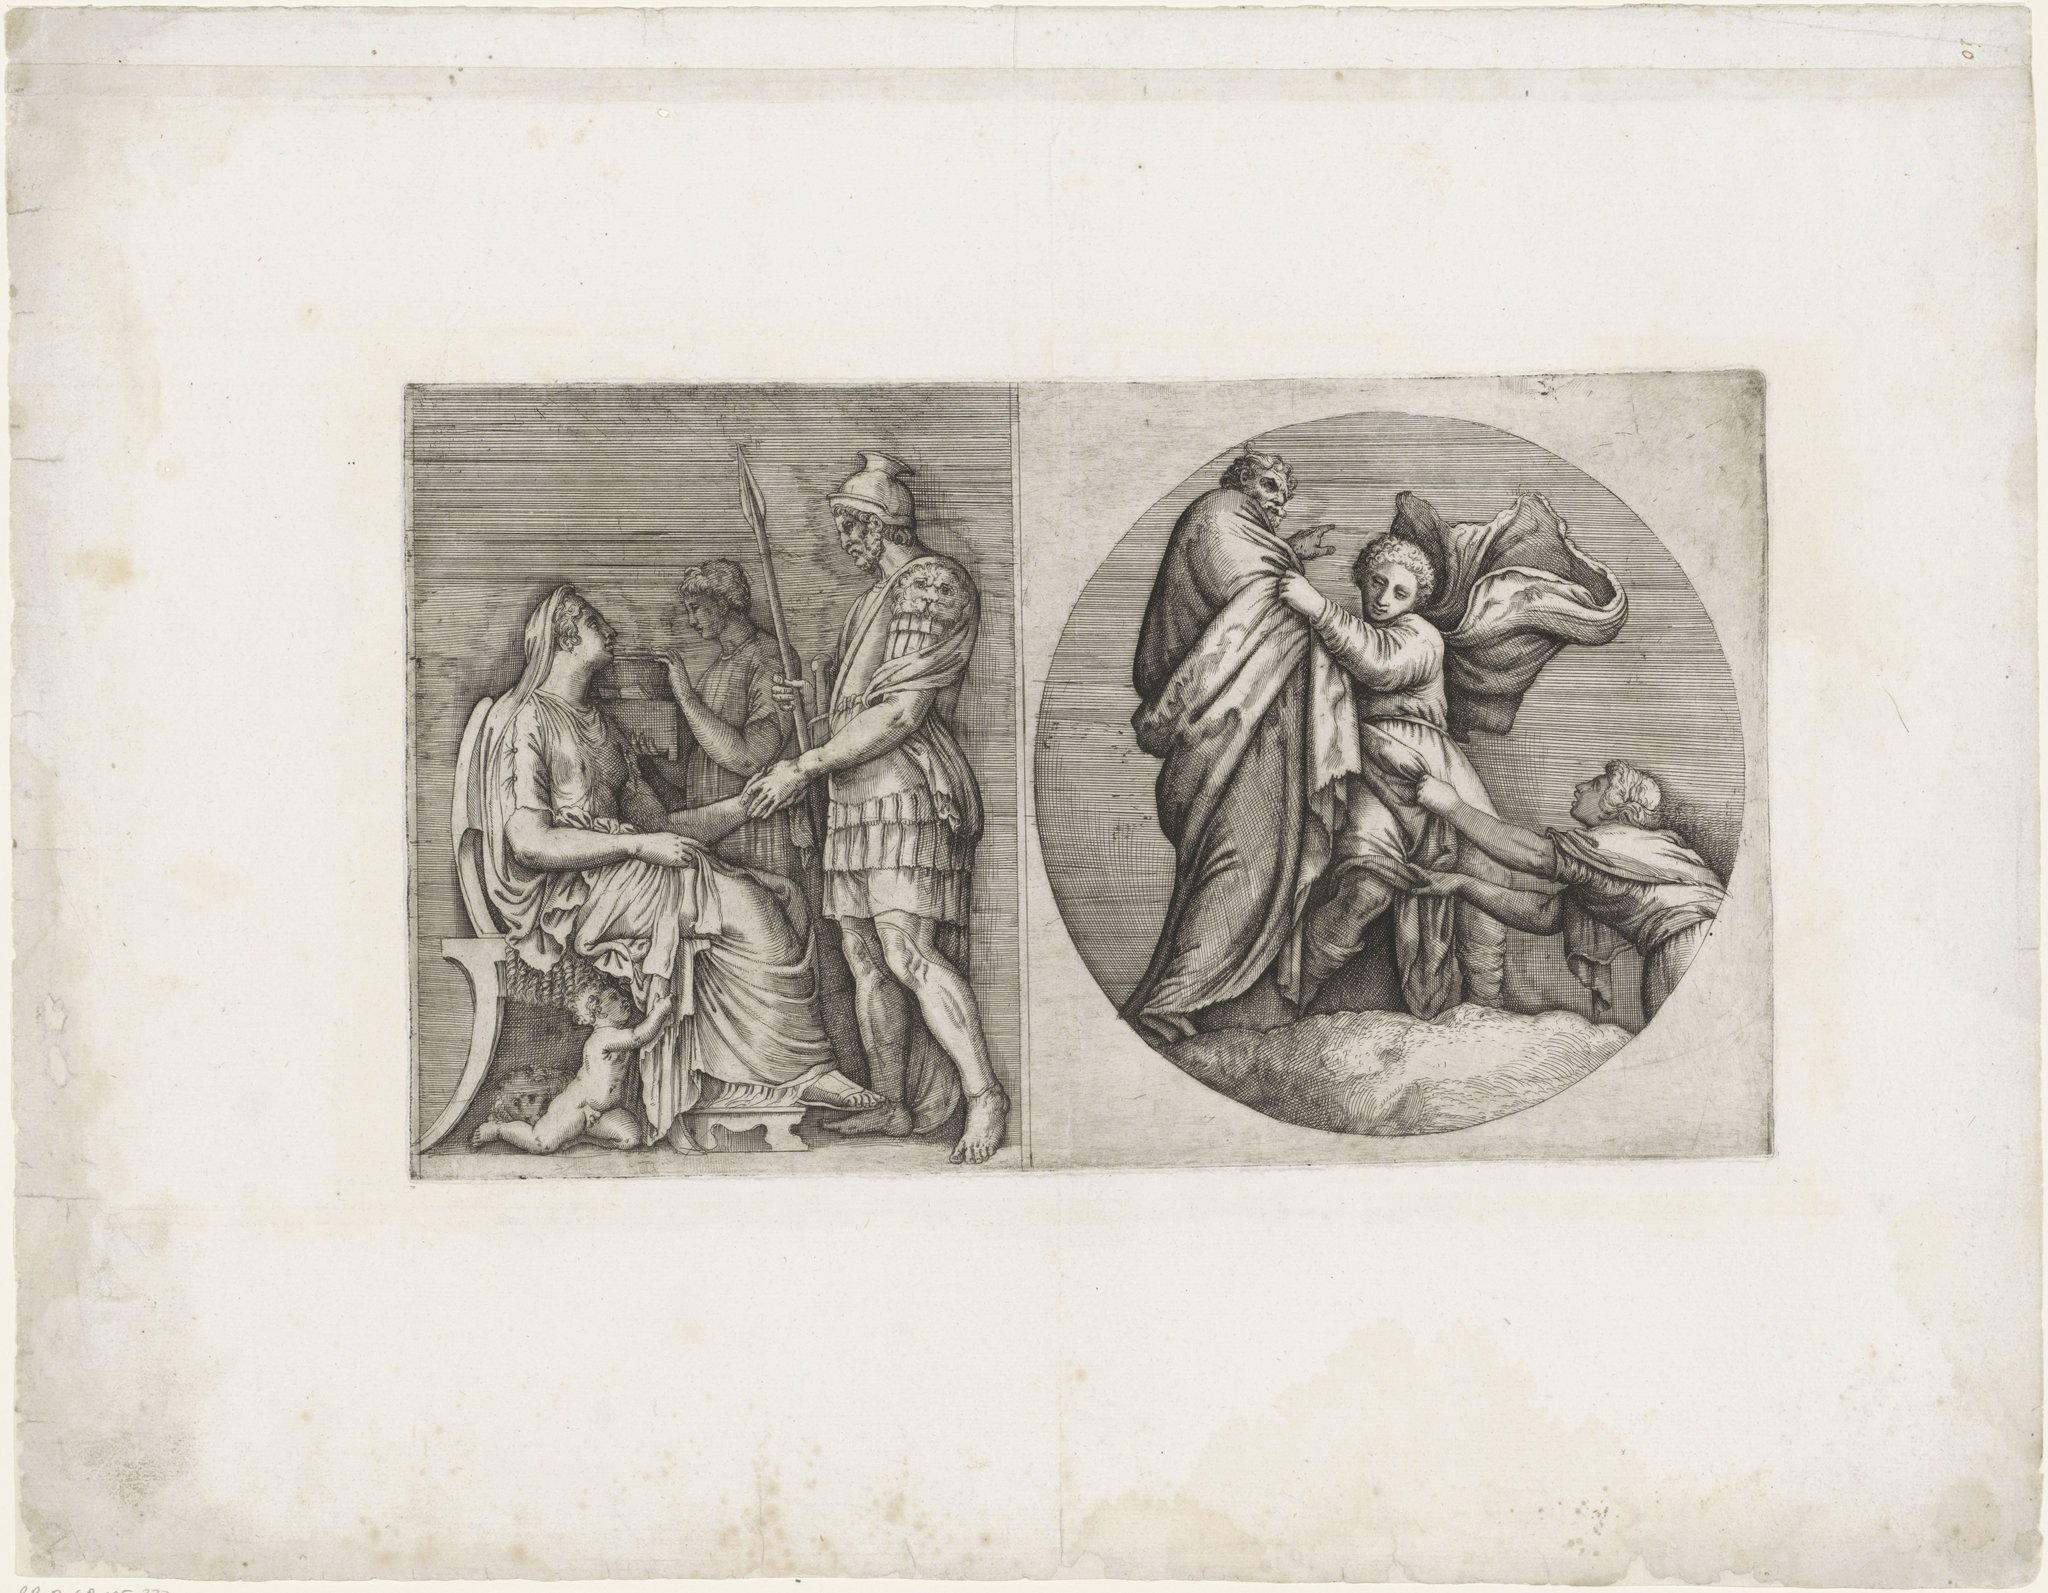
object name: album leaf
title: Romeinse soldaat begroet Romeinse dame / Allegorie: een jongen klampt zich vast aan een oude man, terwijl een vrouw aan zijn gewaad trekt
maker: battista franco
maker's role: draughtsman, painter, print maker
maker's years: 1510-1561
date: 1520-1561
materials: paper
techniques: etching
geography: venice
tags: wisdom; 'sapienza', 'sapienza humana', 'sapienza vera' (ripa), the soldier; the soldier's life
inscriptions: number: ‘10’, collector's mark: Lugt 2228, watermark, collector's mark: Lugt 2760, watermark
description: Folio 10 uit het prentalbum van Johann Georg I. Zobel von Giebelstadt (Röttingen 1543-07-20 - Bamberg 1580-09-07), de latere bisschop van Bamberg. Het album is vermoedelijk samengesteld tussen 1568 en 1570 in Venetië. Het album werd in 1999 uit elkaar genomen door een antiquair. De in totaal 124 folio's met prenten uit het "Zobel Album" werden aangekocht door verschillende musea en privéverzamelingen. De grootste groep (68 folio's) bevindt zich in de collectie van het Rijksmuseum. De rechter voorstelling is naar een detail uit het plafondfresco door Giovanni Battista Franco in de Grimani kapel, in de S. Francesco della Vigna in Venetië.